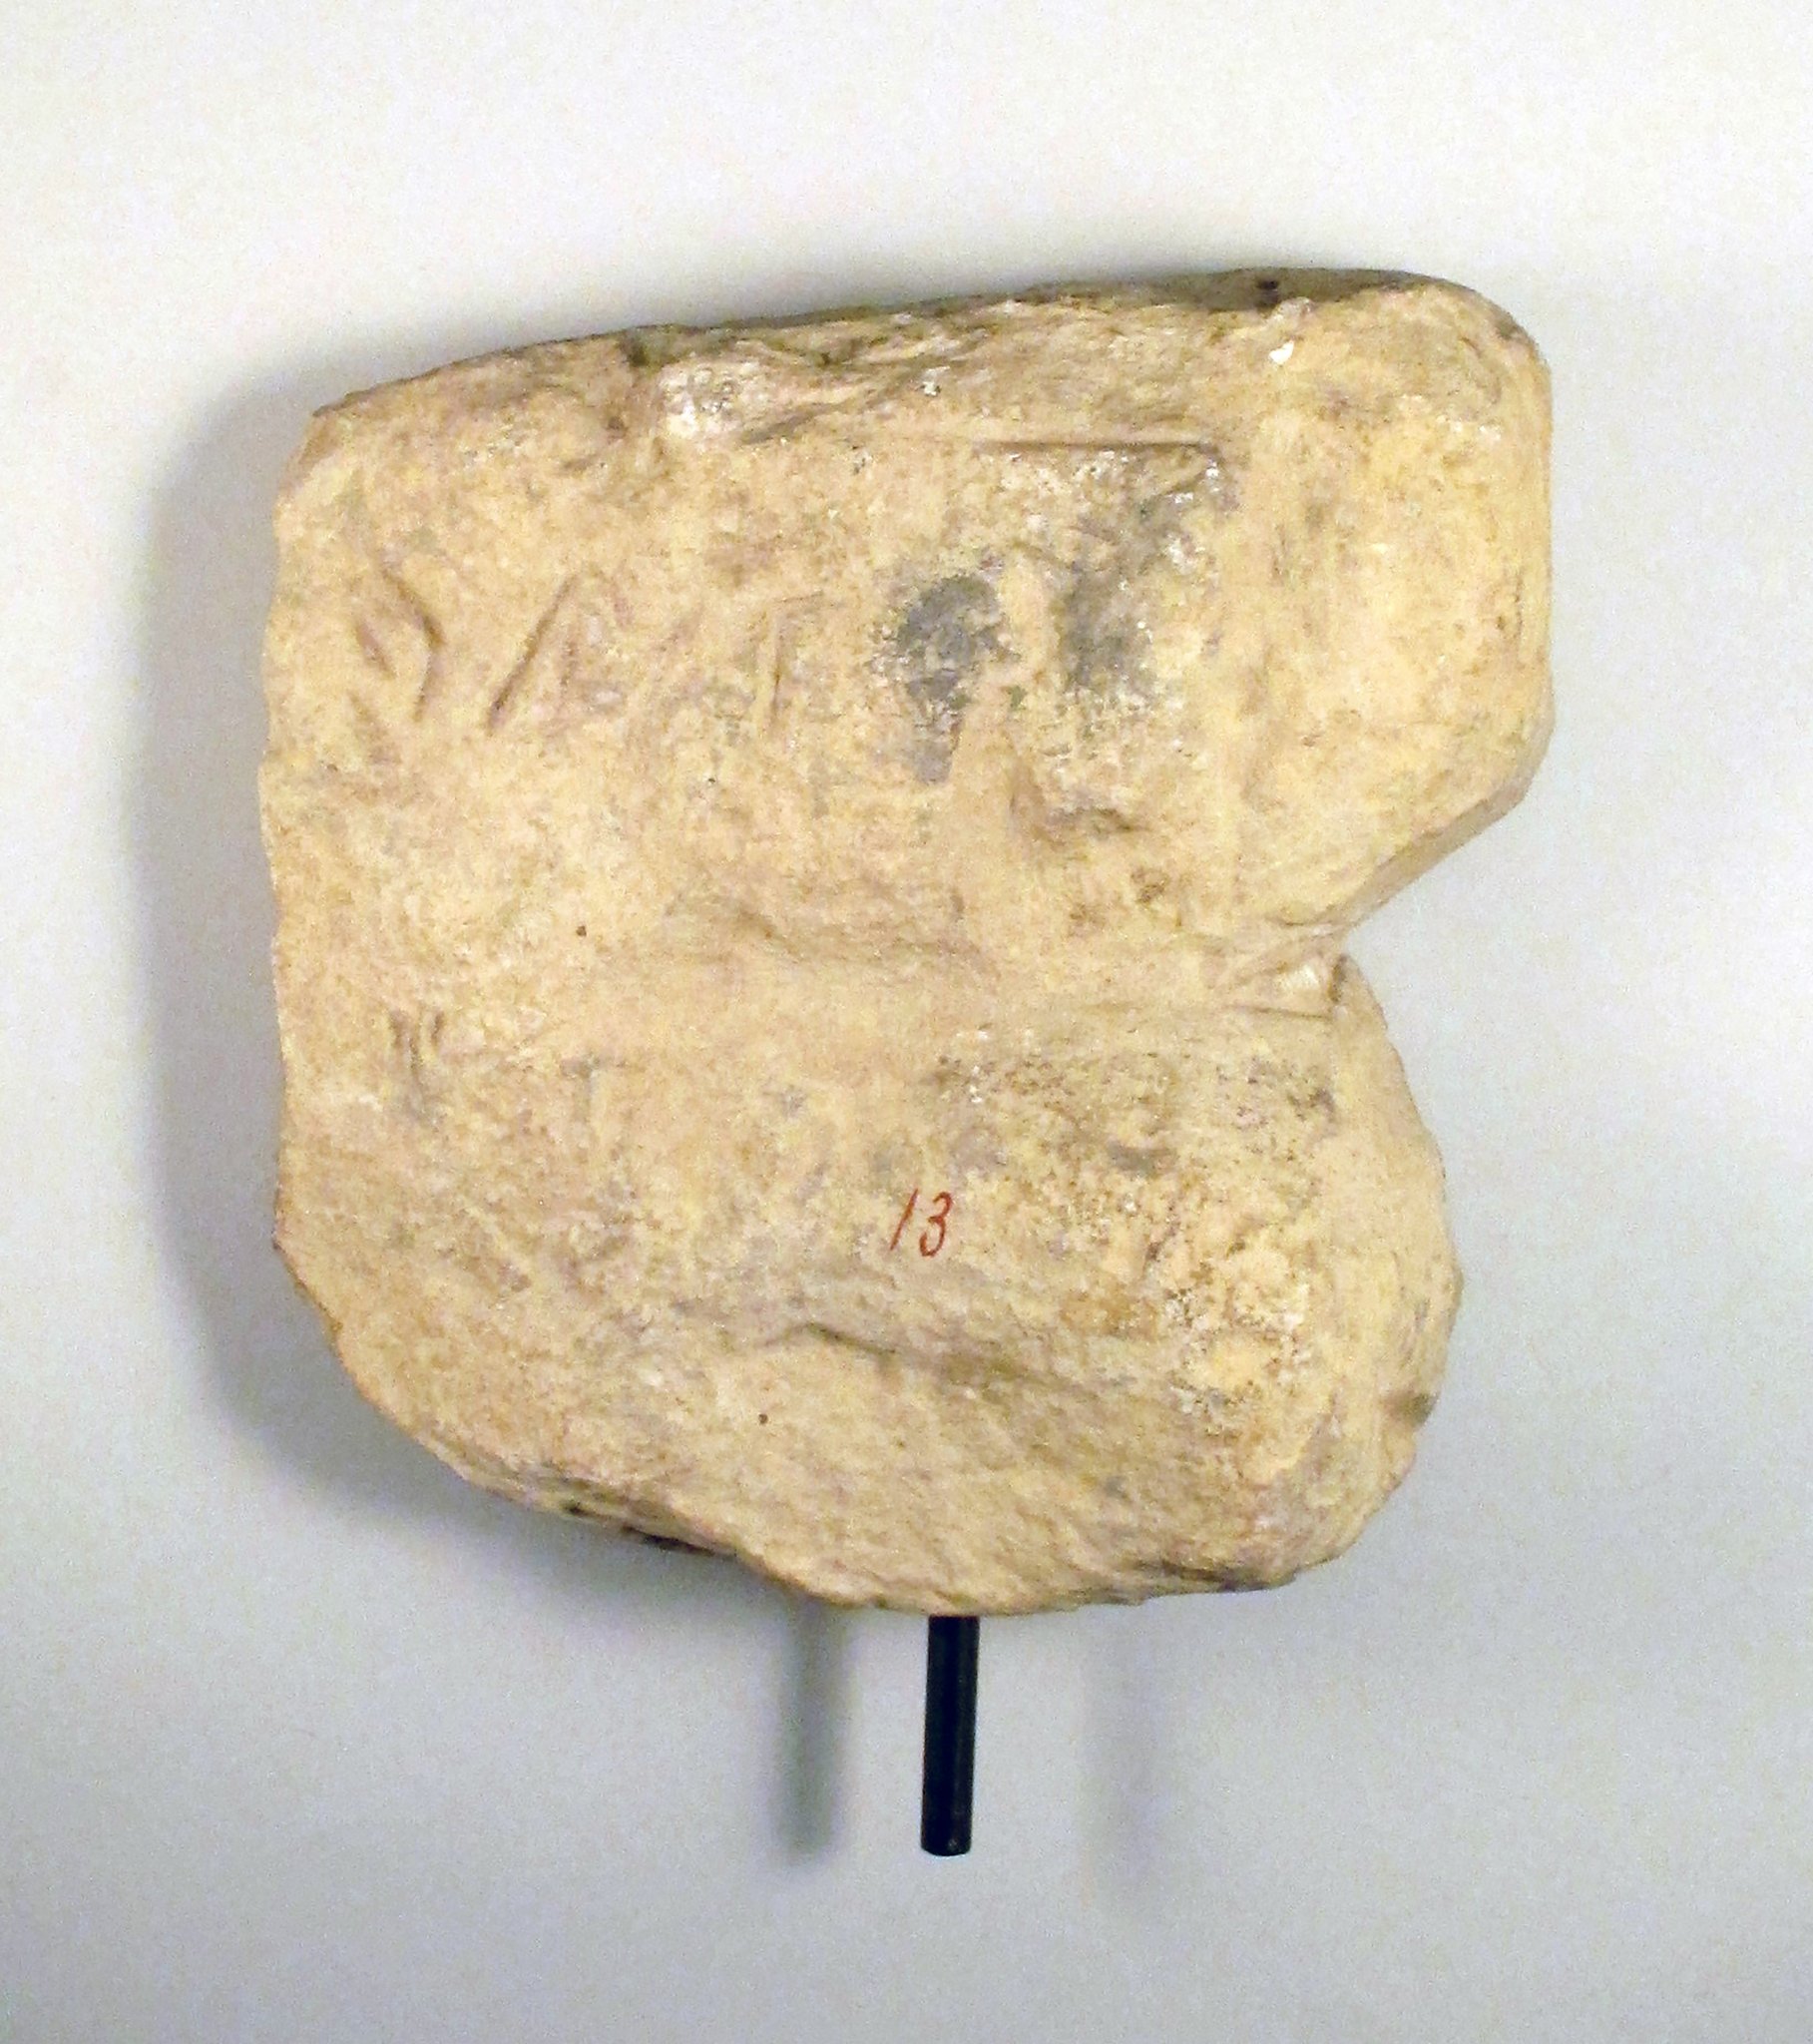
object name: block wall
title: Limestone inscribed block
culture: cypriot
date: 3900 BCE-100 CE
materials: limestone